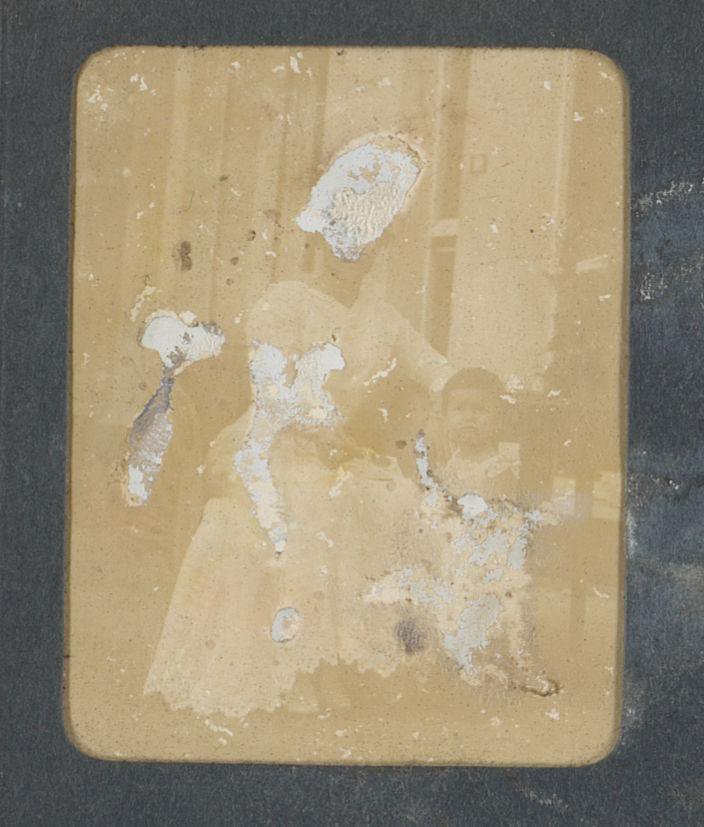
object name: photograph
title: Onbekende vrouw met kind, mogelijk in Indonesië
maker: Anonymous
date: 1908-1912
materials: paper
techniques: gelatin silver print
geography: indonesia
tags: toddler, adult woman, indonesia